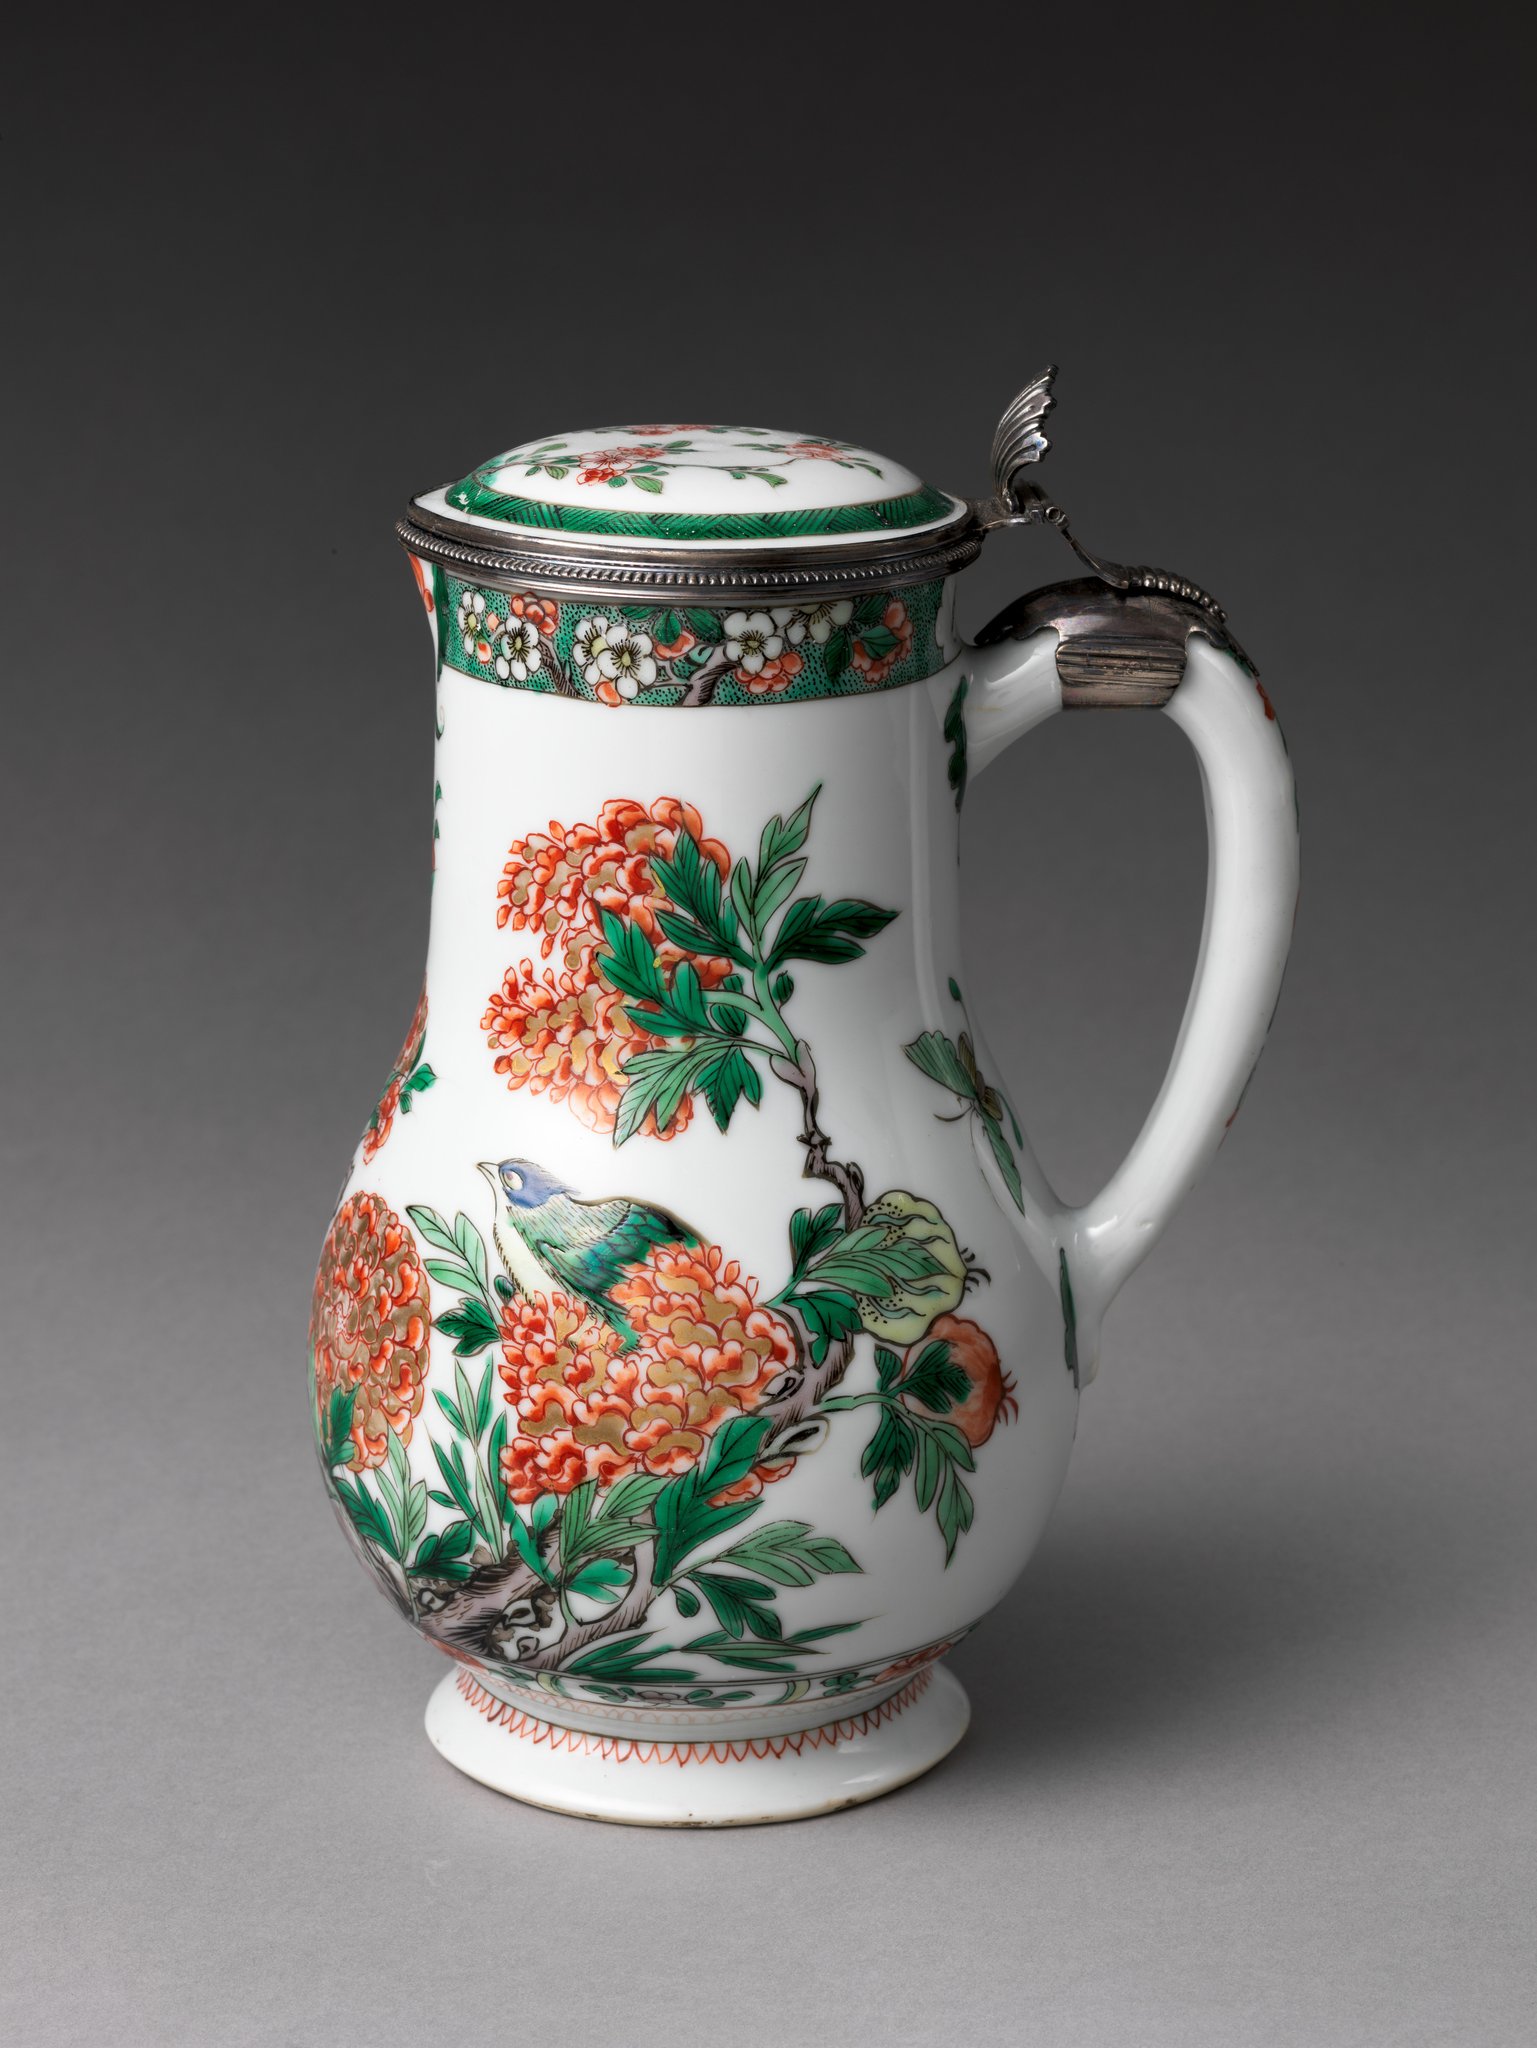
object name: jug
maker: paul le riche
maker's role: maker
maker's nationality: french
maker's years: 1686-1738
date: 1725-1730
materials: enamel, glaze, hard paste porcelain, silver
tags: birds,flowers